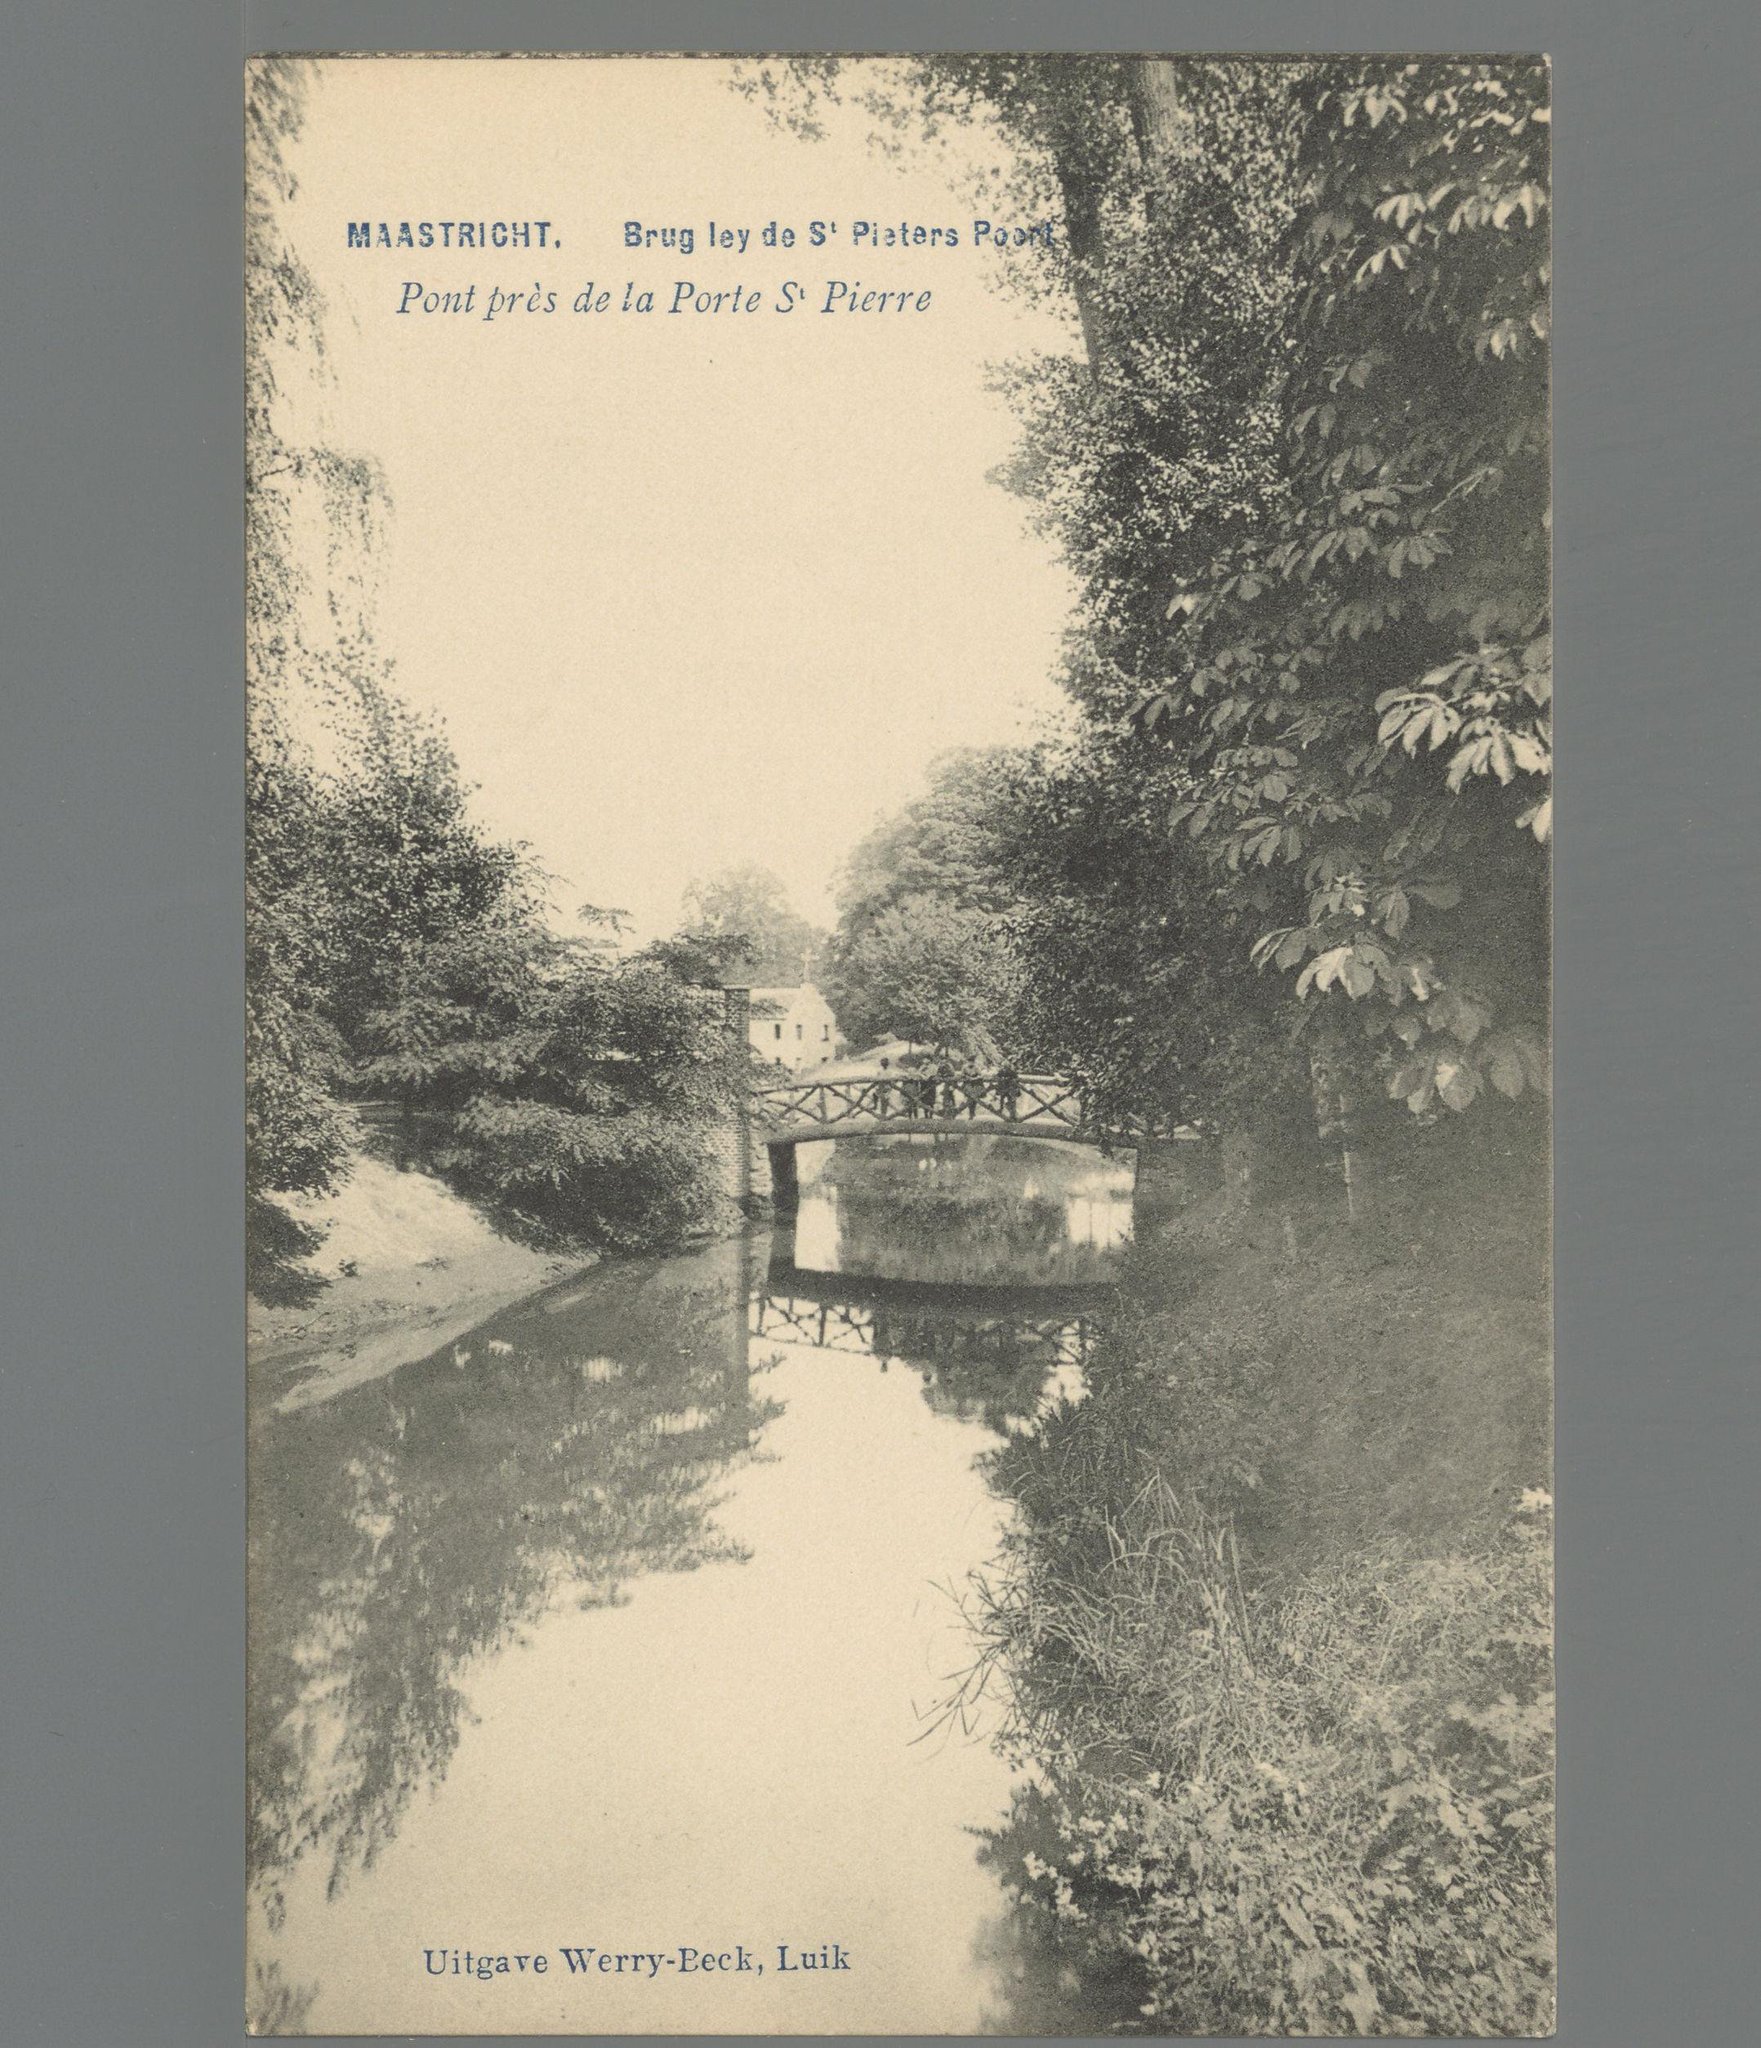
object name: ansichtkaart, prentbriefkaart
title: Maastricht. Brug ley de St Pieters Poort / Pont près de la Porte St Pierre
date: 1905-1906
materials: cardboard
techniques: photograph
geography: liège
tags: customs, bridge in village across river, canal, etc.